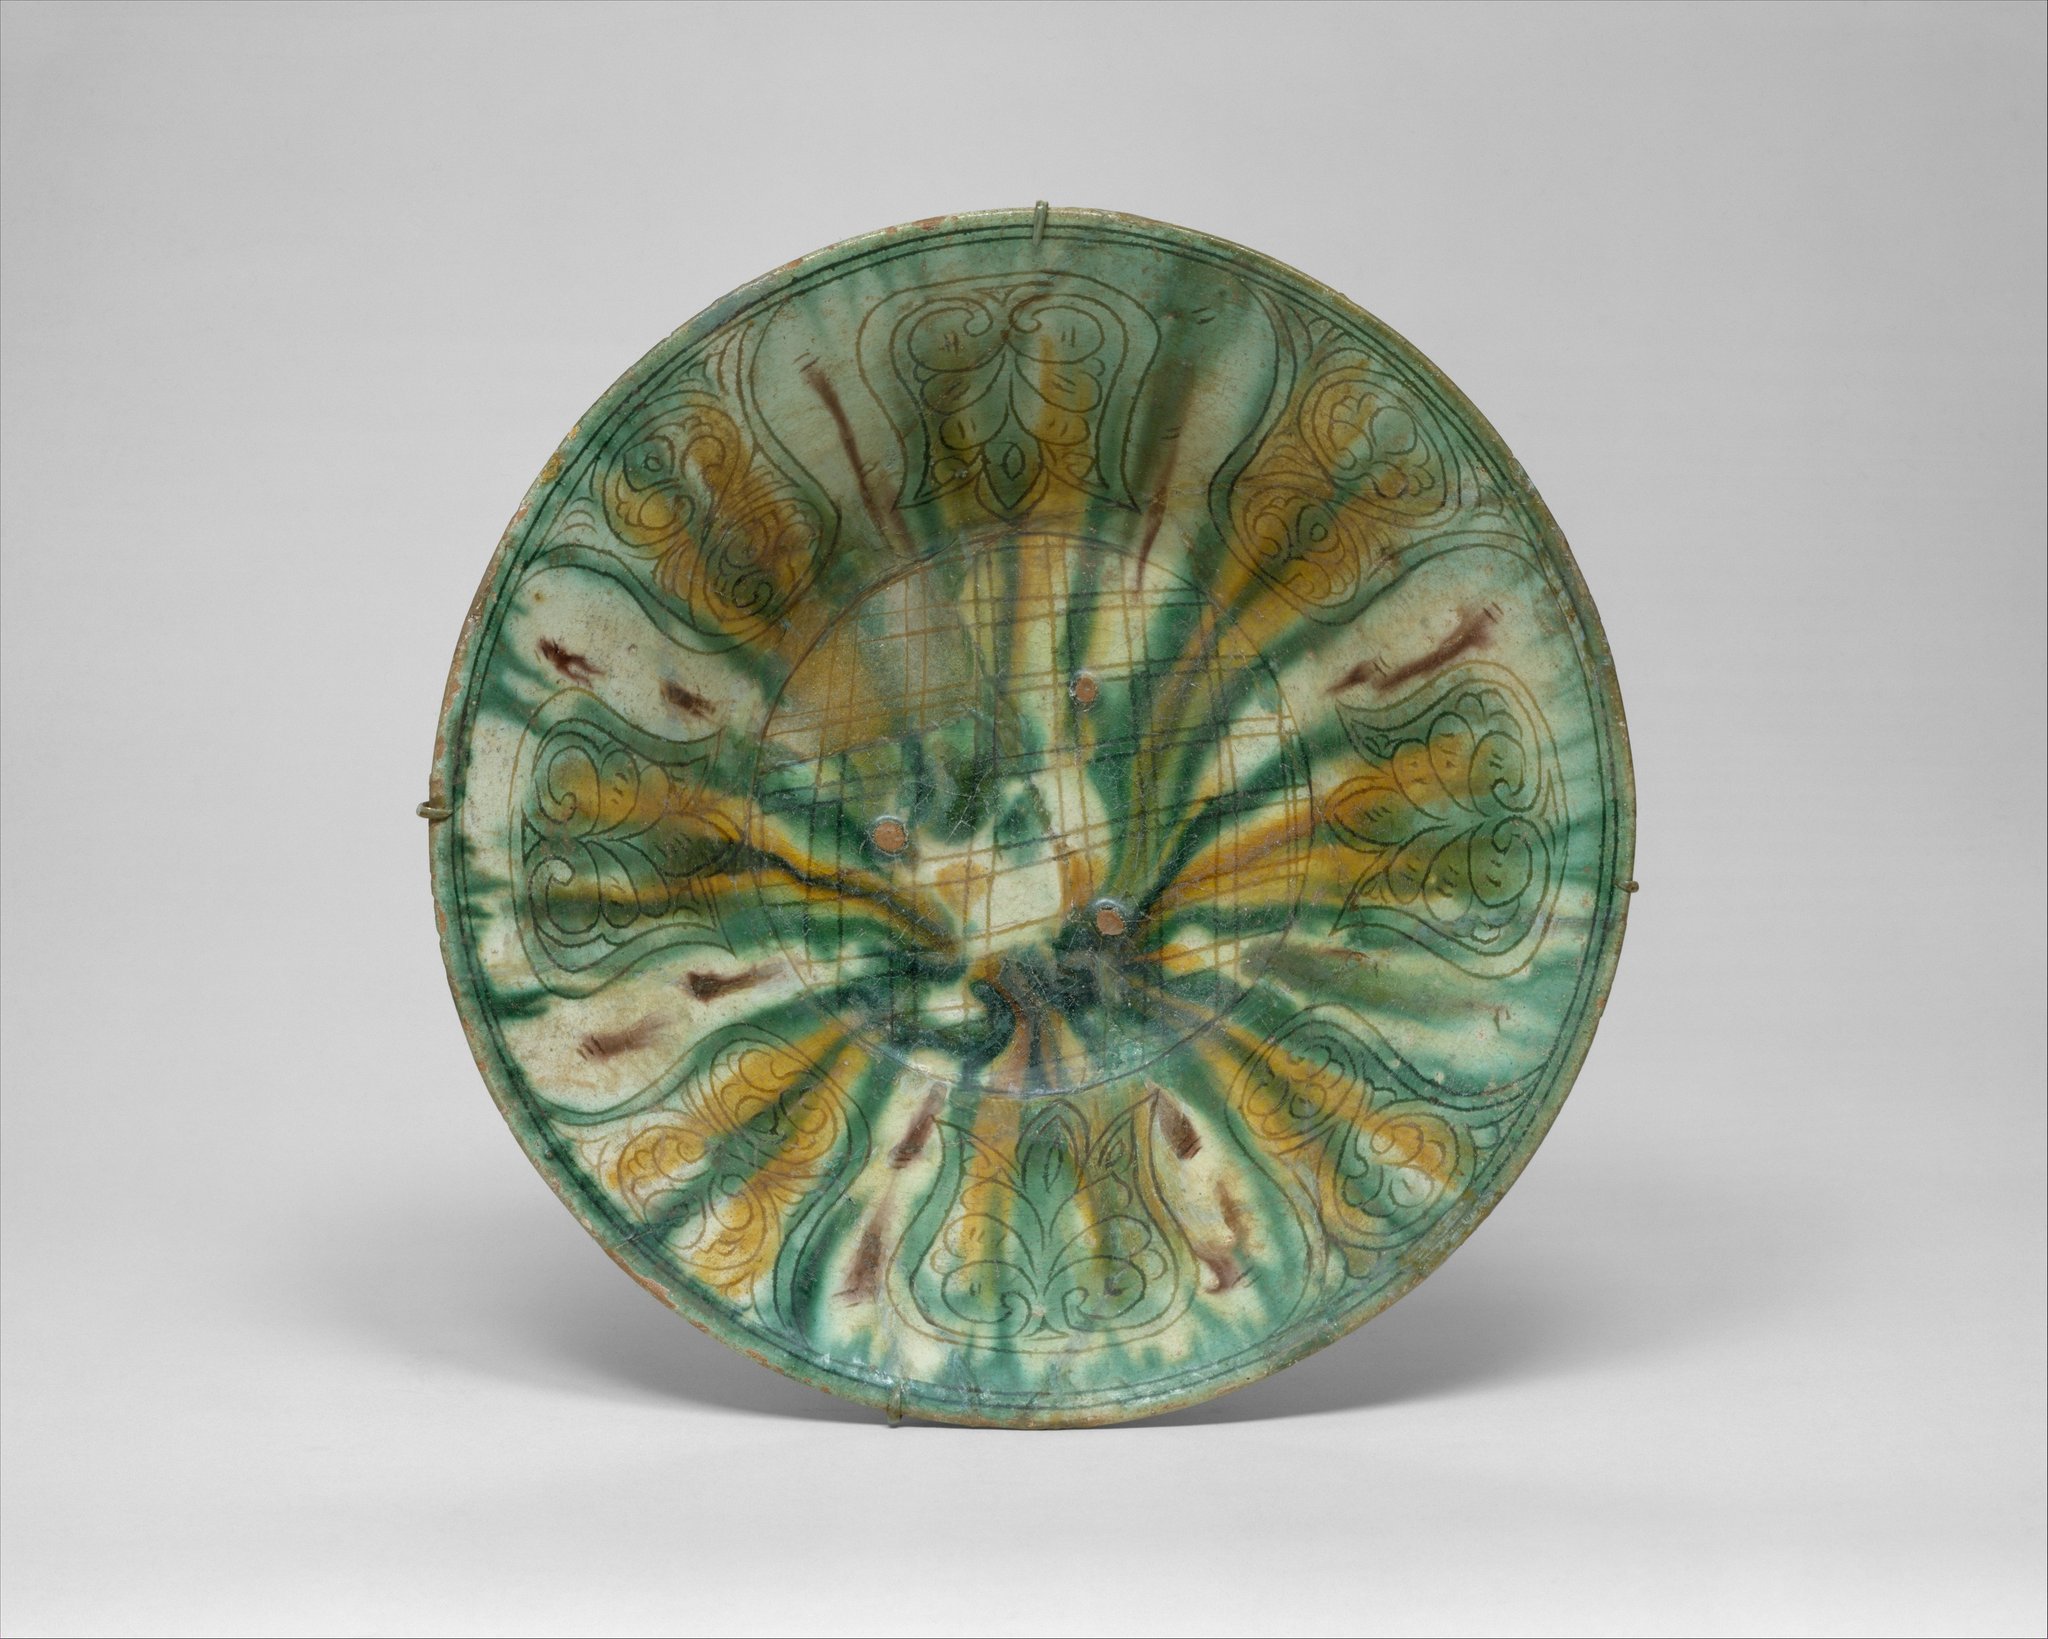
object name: bowl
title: Bowl with Green, Yellow, and Brown Splashed Decoration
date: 901-1000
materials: earthenware, glaze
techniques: incising, polychrome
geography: iran